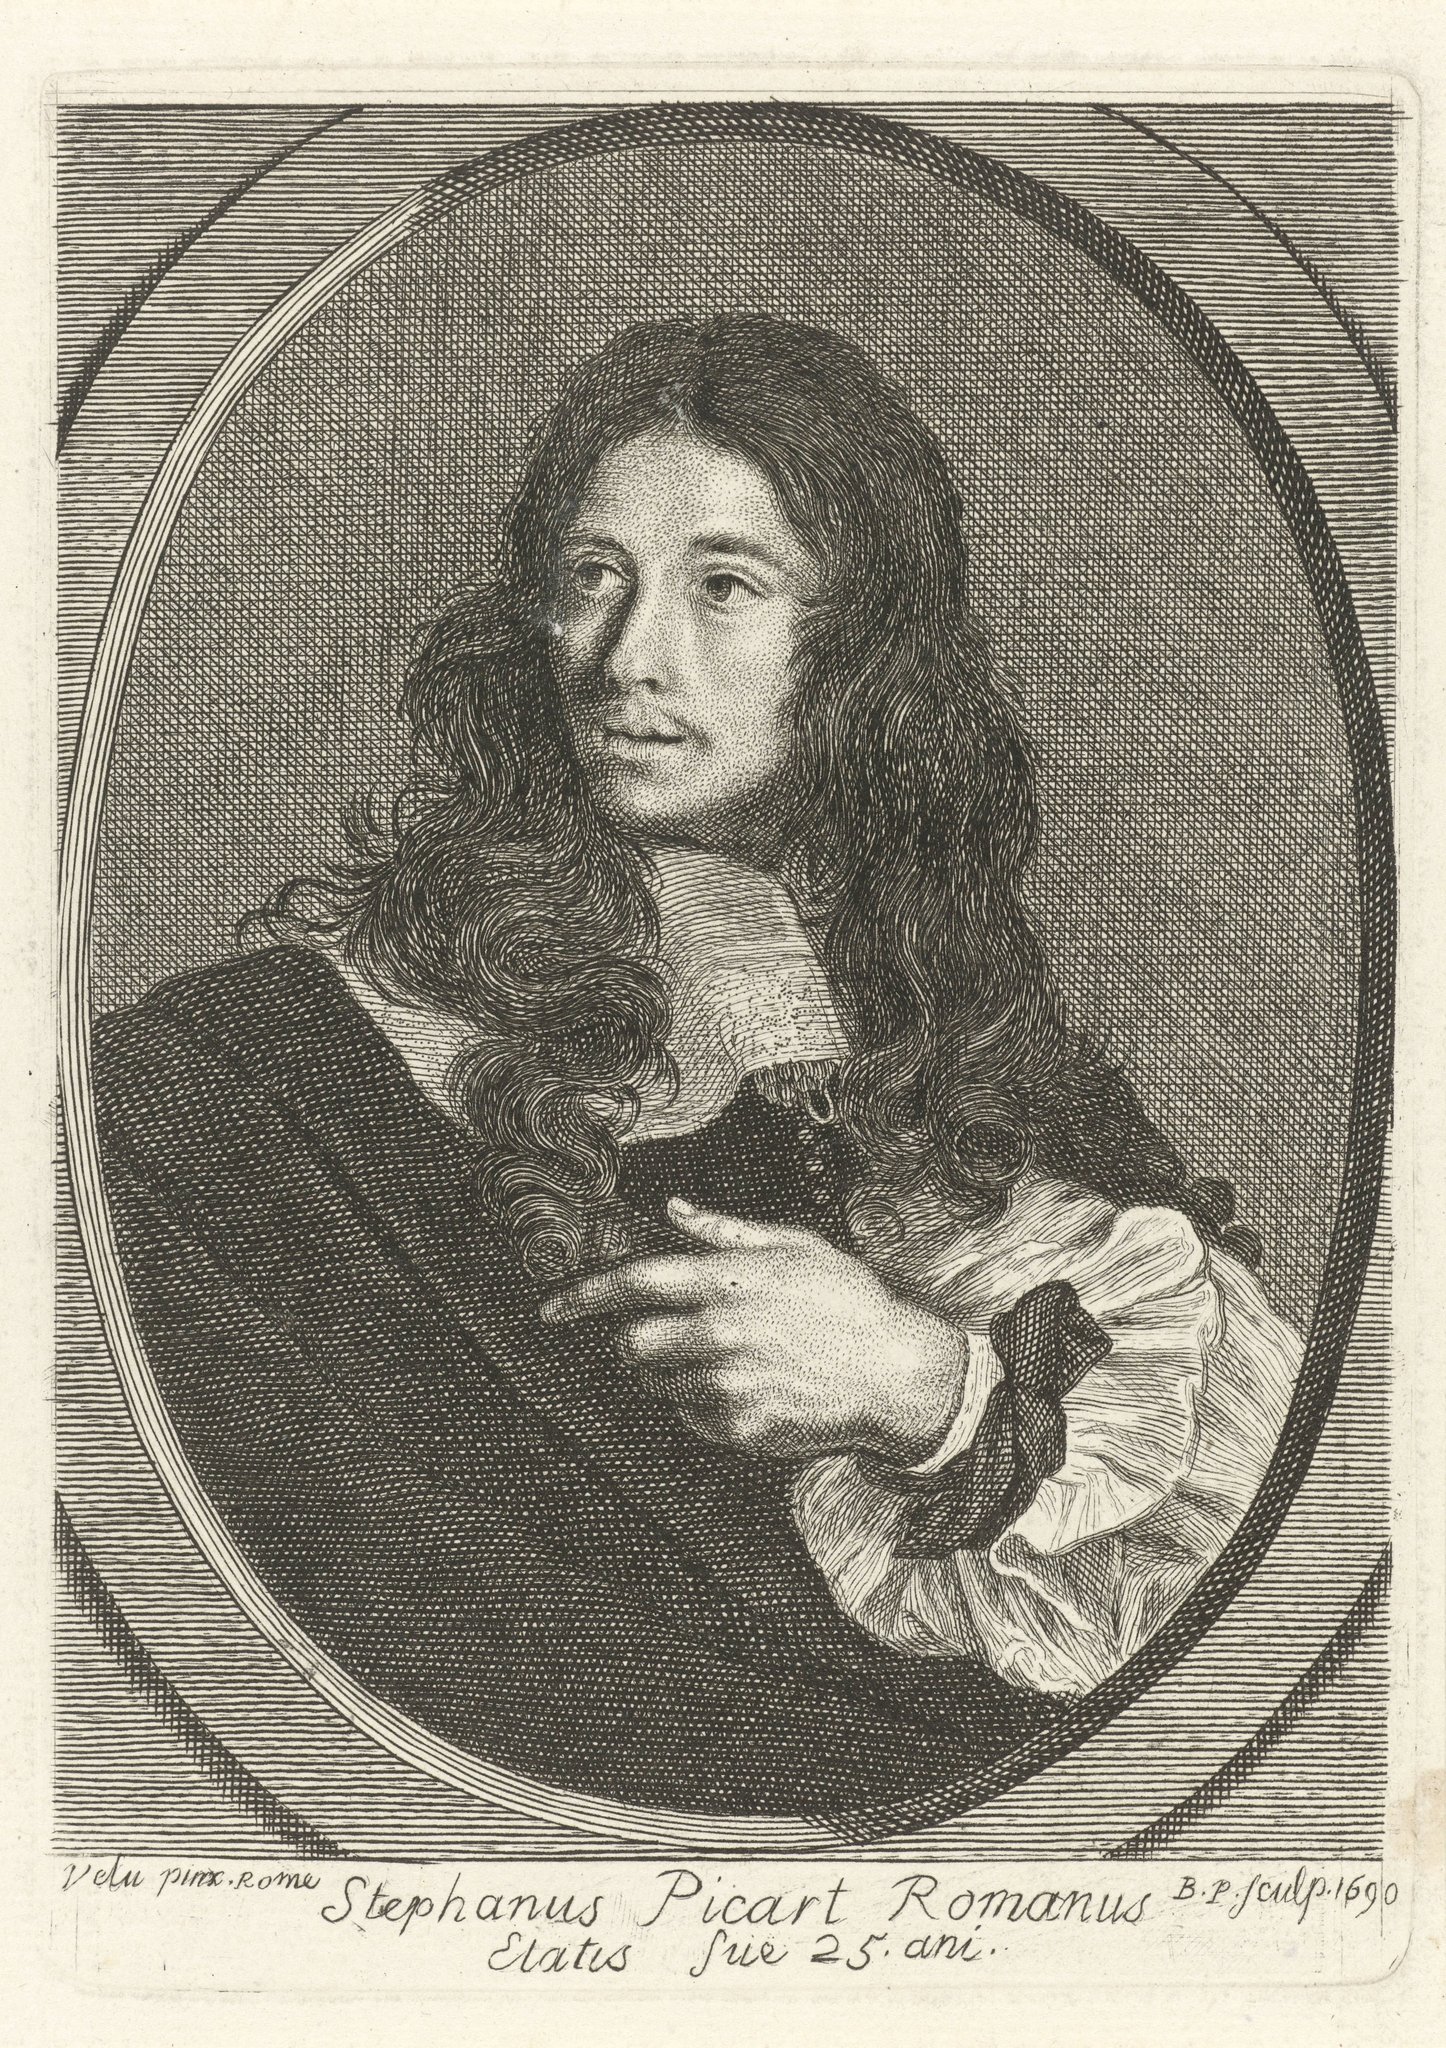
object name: print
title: Portret van Etienne Picart op 25-jarige leeftijd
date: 1690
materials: paper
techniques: engraving, etching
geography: paris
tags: paris, amsterdam, print maker, draughtsman, etienne picart, historical persons, portrait, self-portrait of graphic artist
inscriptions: collector's mark: Lugt 2760, collector's mark: Lugt 2228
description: Portret van Etienne (Stephanus) Picart, ook wel 'de Romein' genoemd, op 25-jarige leeftijd. Hij is de vader van de kunstenaar.